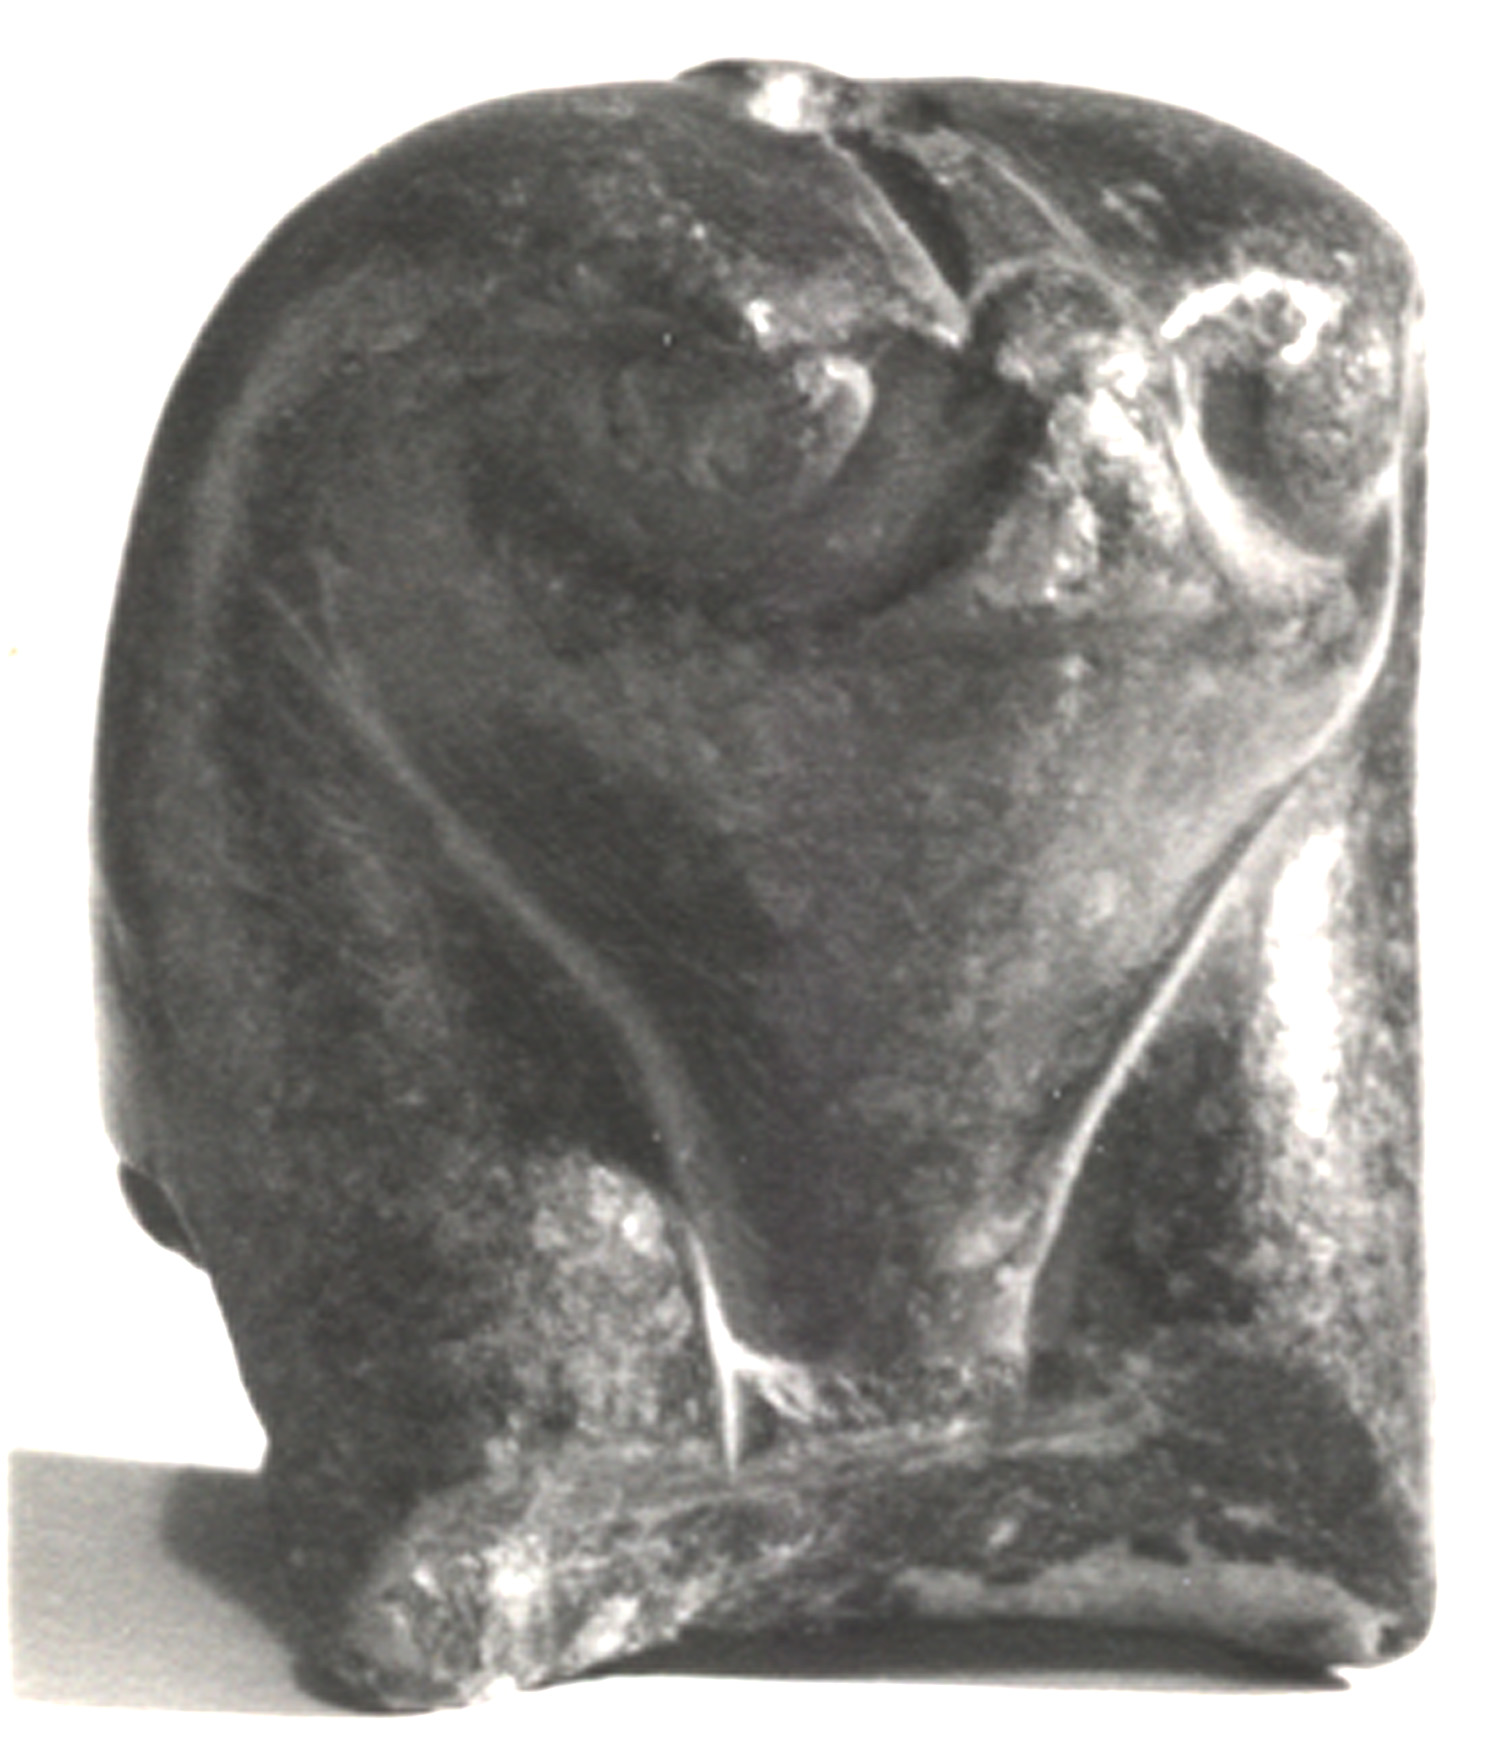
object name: head, falcon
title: Head of falcon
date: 712-343 BCE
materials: stone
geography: egypt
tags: falcons